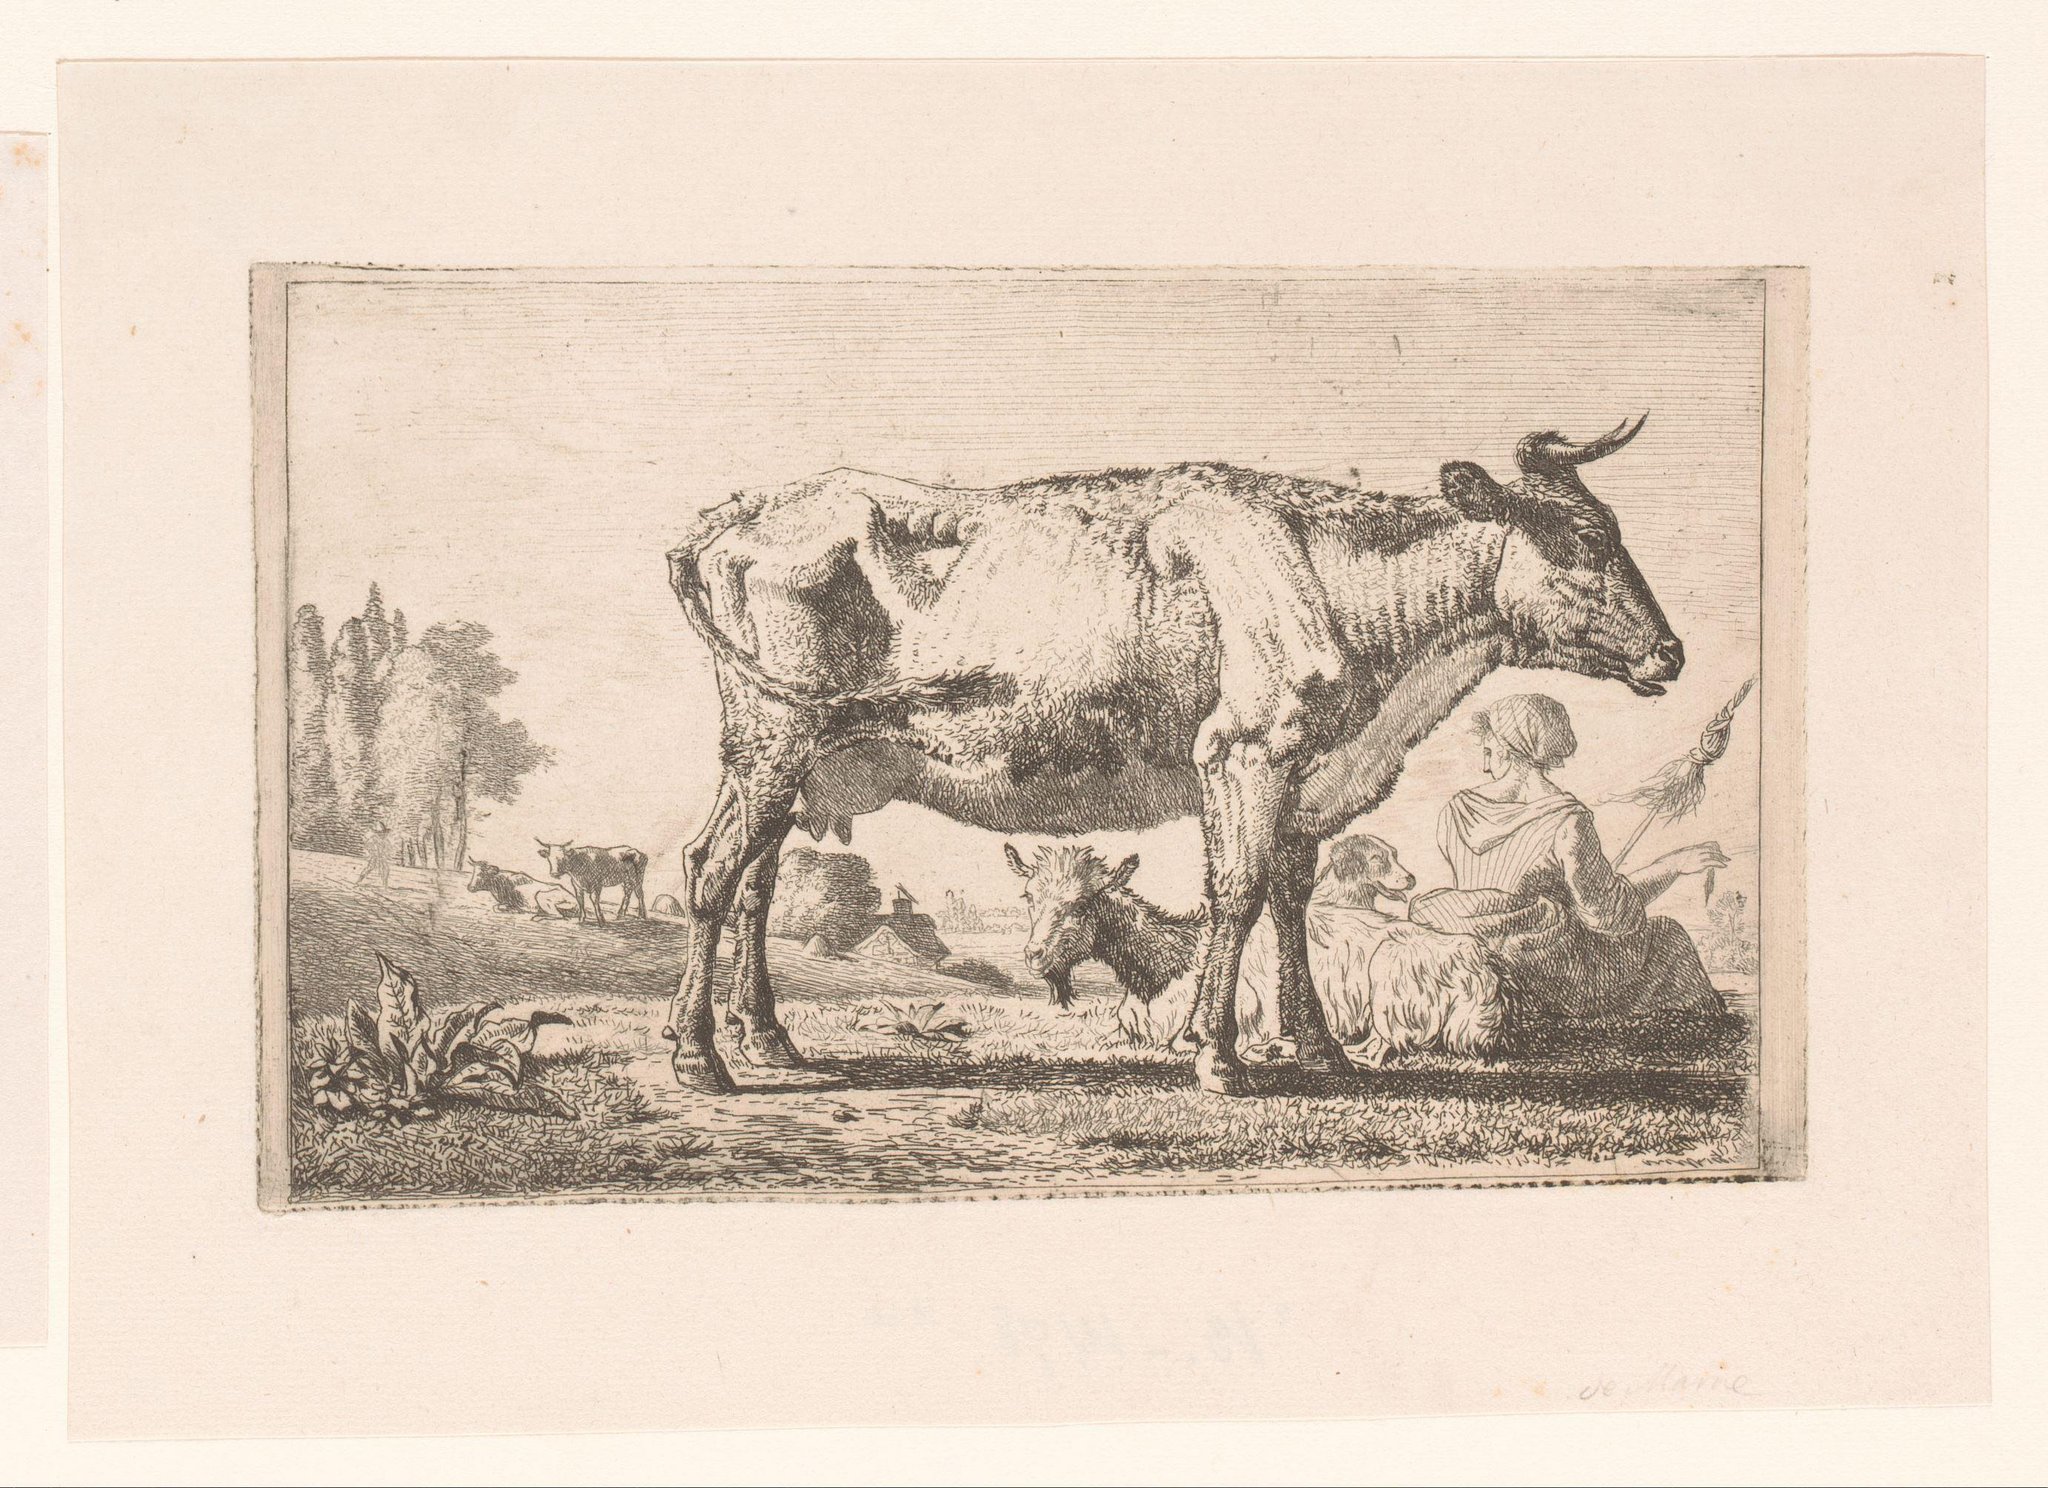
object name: print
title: Landschap met koe en geit bij een spinster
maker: jean louis demarne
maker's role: draughtsman, painter, print maker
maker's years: 1752-1829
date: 1762-1829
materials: paper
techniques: etching, intaglio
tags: cow, goat, spinning (manufacture of yarn)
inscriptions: collector's mark: Lugt 2228, collector's mark: Lugt 1485